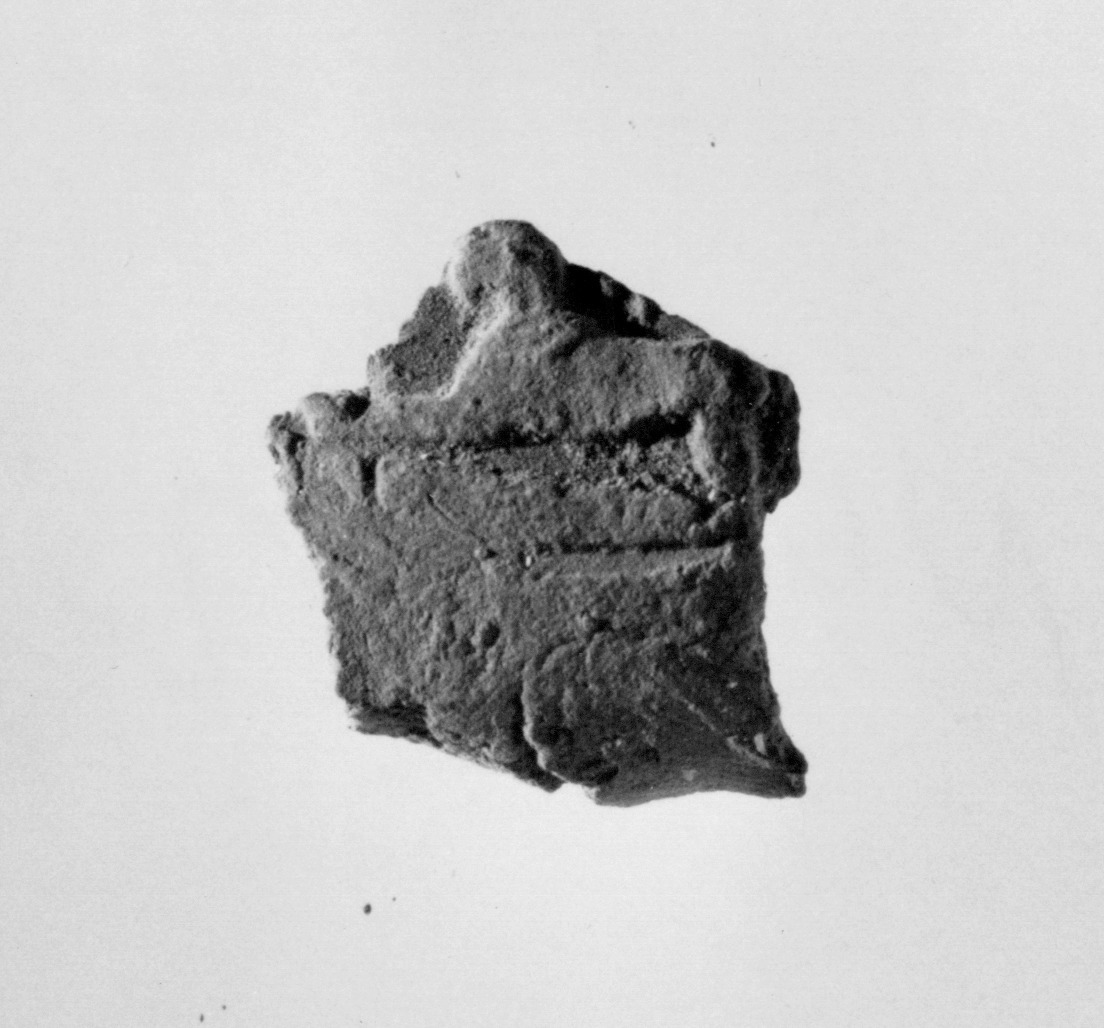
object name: sealing, recumbant sphinx, ankh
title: Document Sealing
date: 1390-1352 BCE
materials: mud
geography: egypt